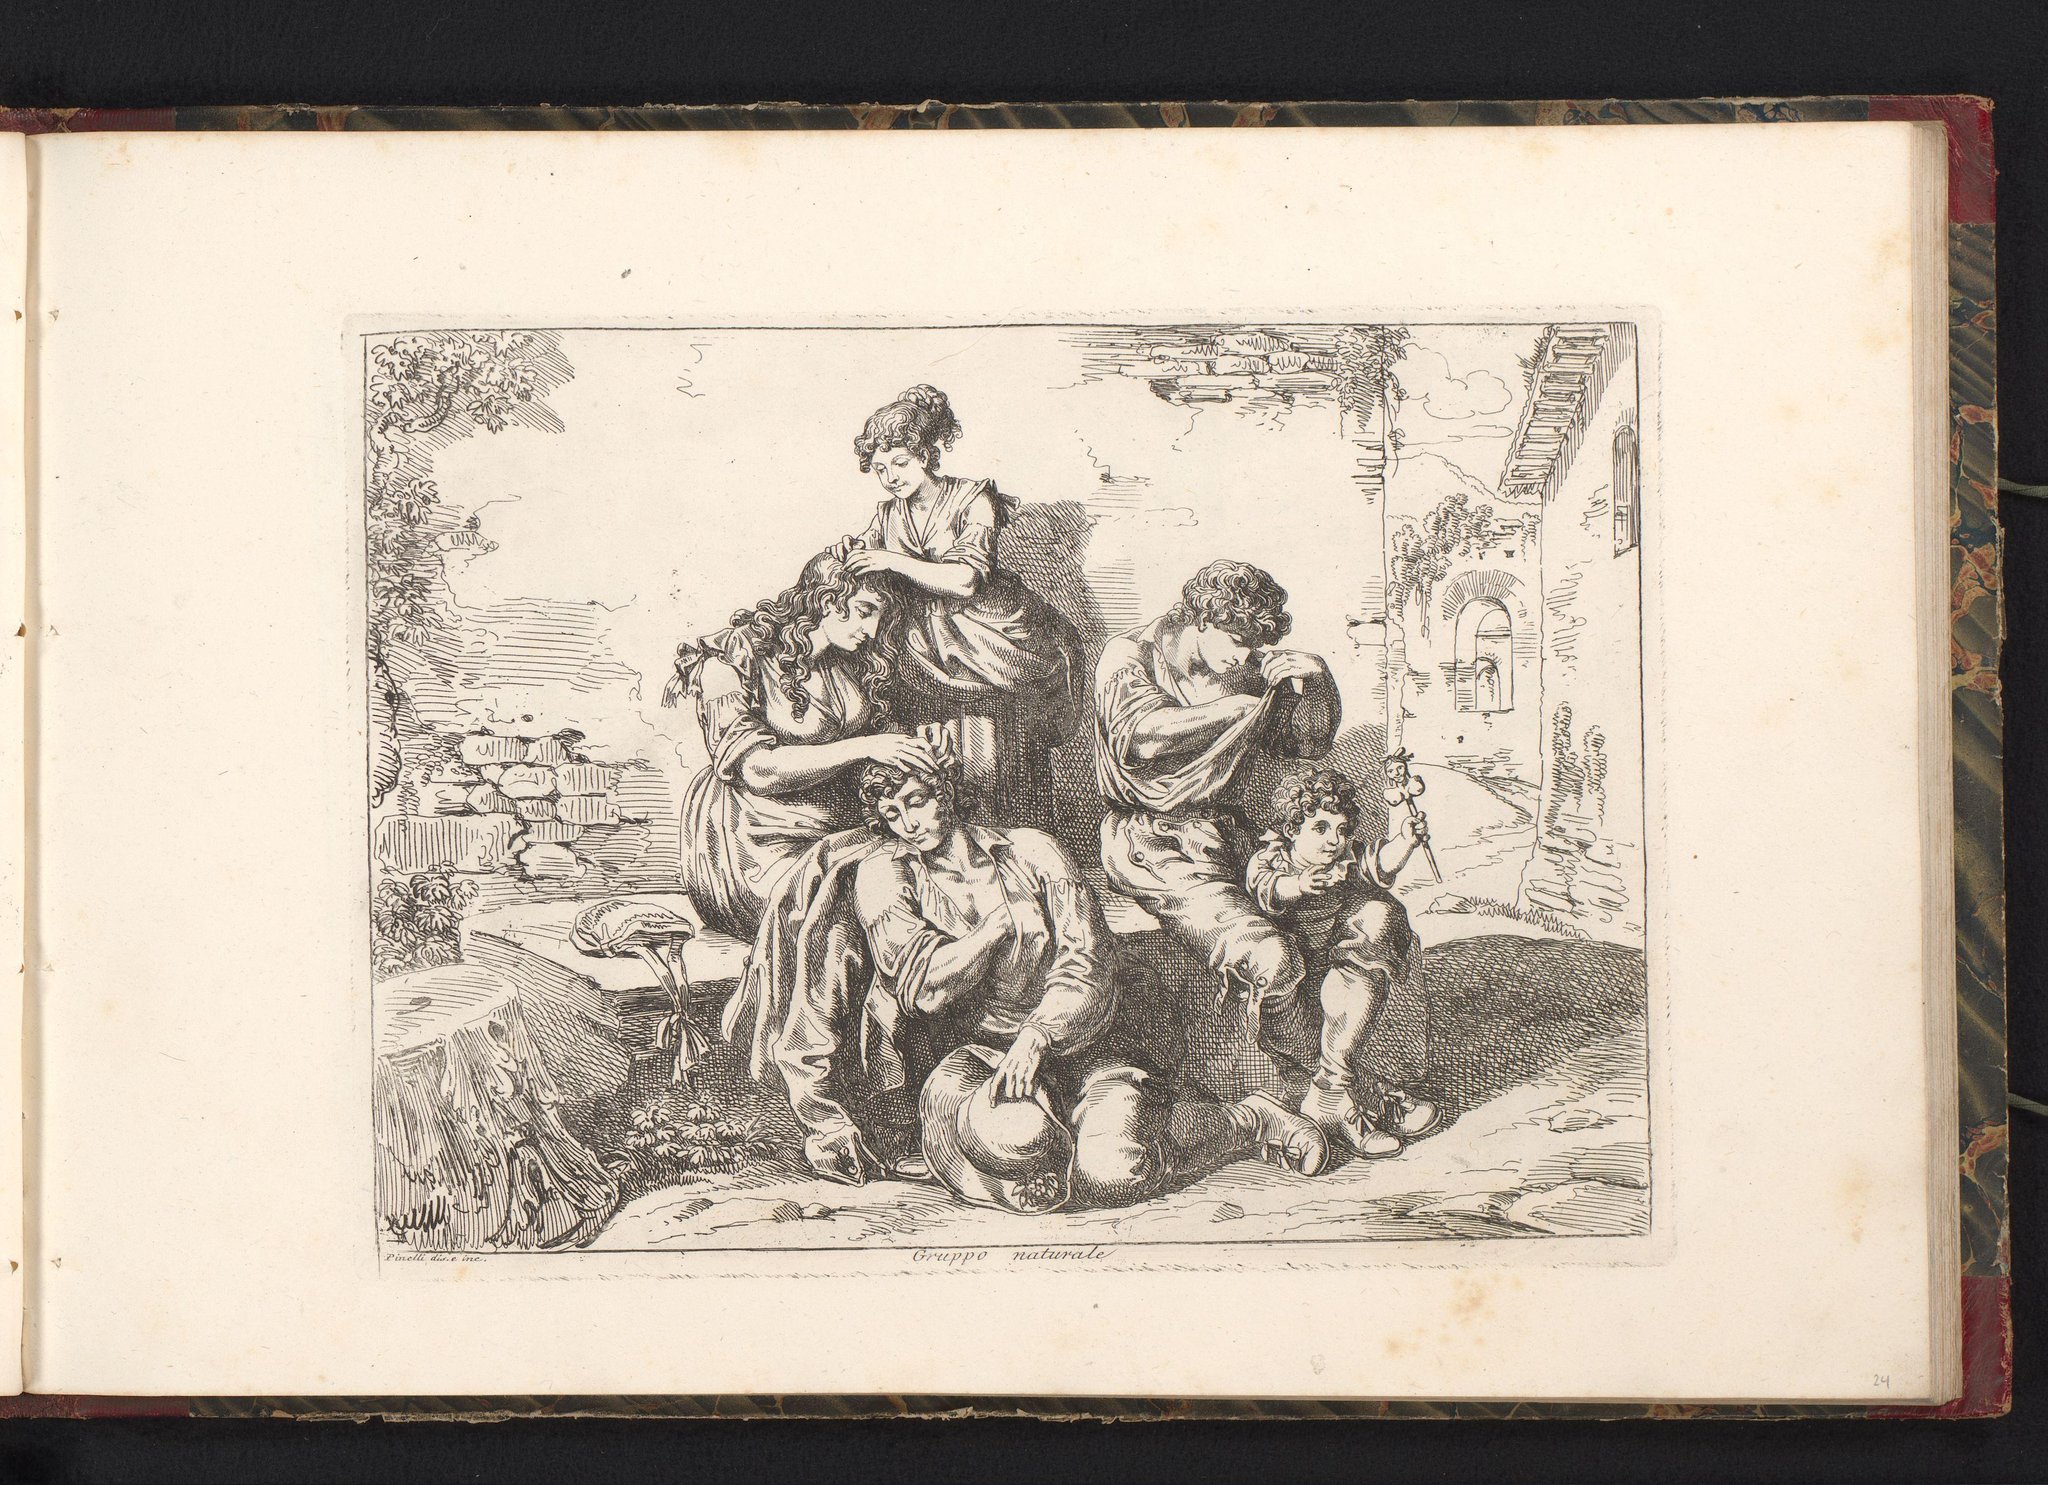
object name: album leaf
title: Kostuumprenten met figuren uit Rome en omgeving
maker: bartolomeo pinelli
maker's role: draughtsman, print maker, sculptor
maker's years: 1781-1835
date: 1819-1823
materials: paper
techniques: etching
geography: rome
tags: (playing with) dolls, folk costume, regional costume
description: Tegen een muur zitten twee mannen, twee vrouwen en een kind. Drie van hen bestuderen elkaars haren. Het kind houdt een pop on een stokje in de hand. De prent maakt deel uit van een album.